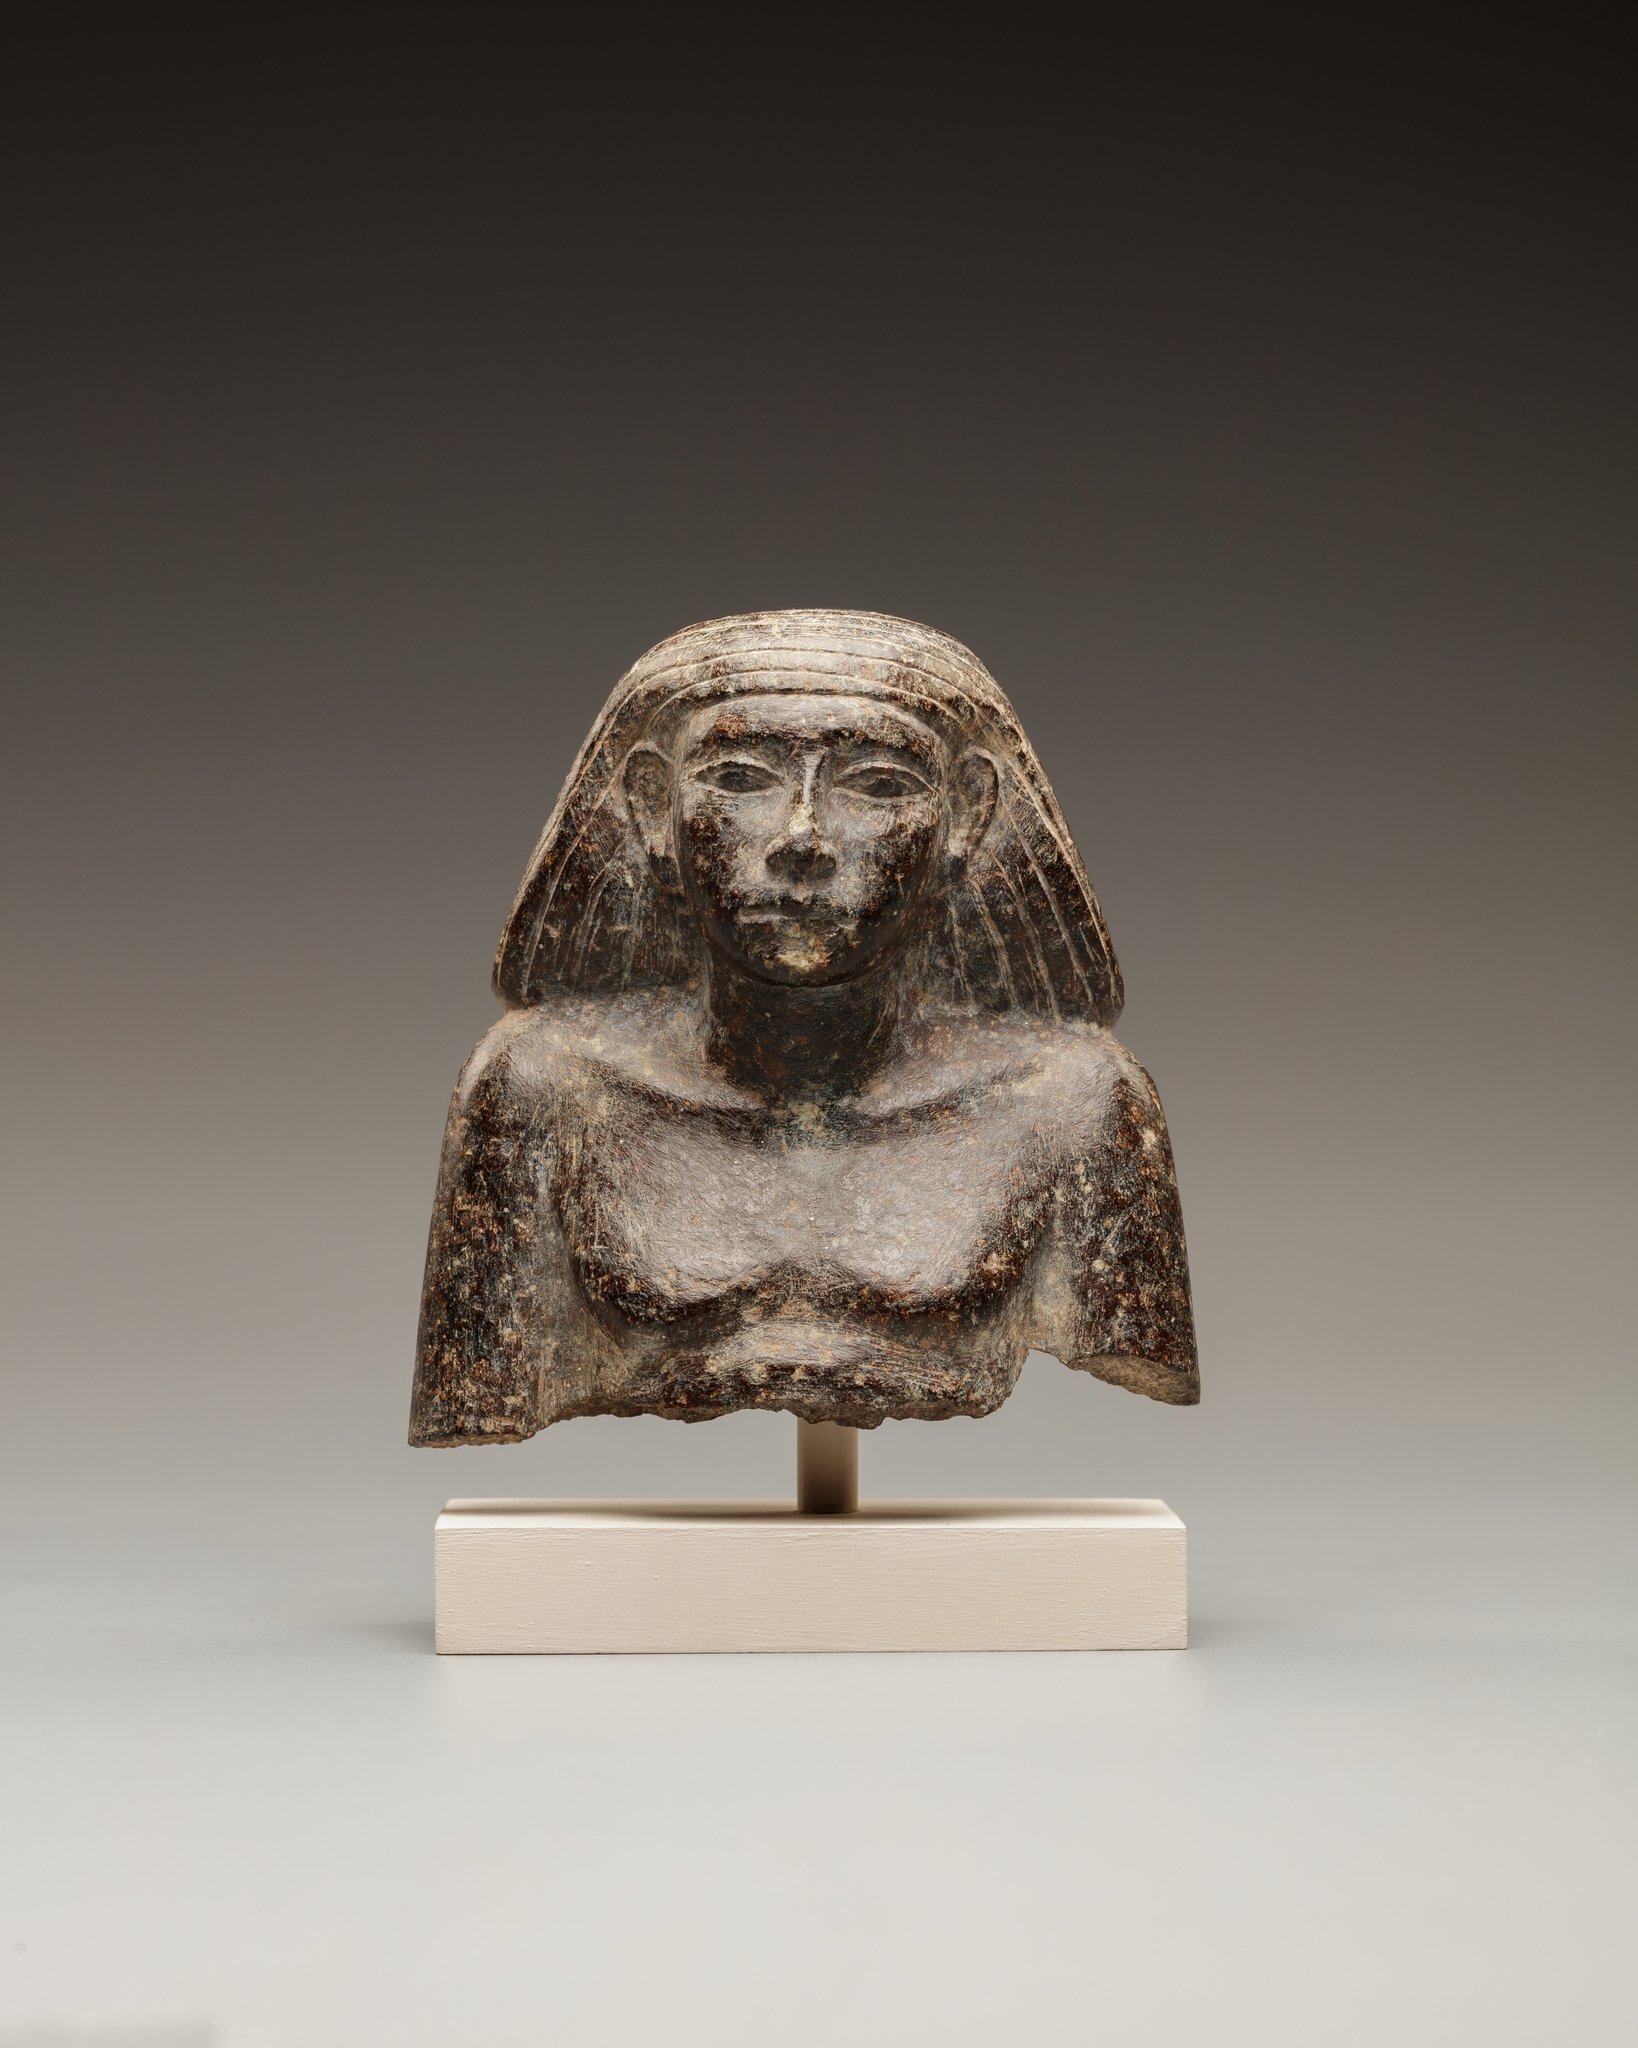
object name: bust, man, upper part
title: Bust of upper part of man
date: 1981-1640 BCE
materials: stone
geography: egypt